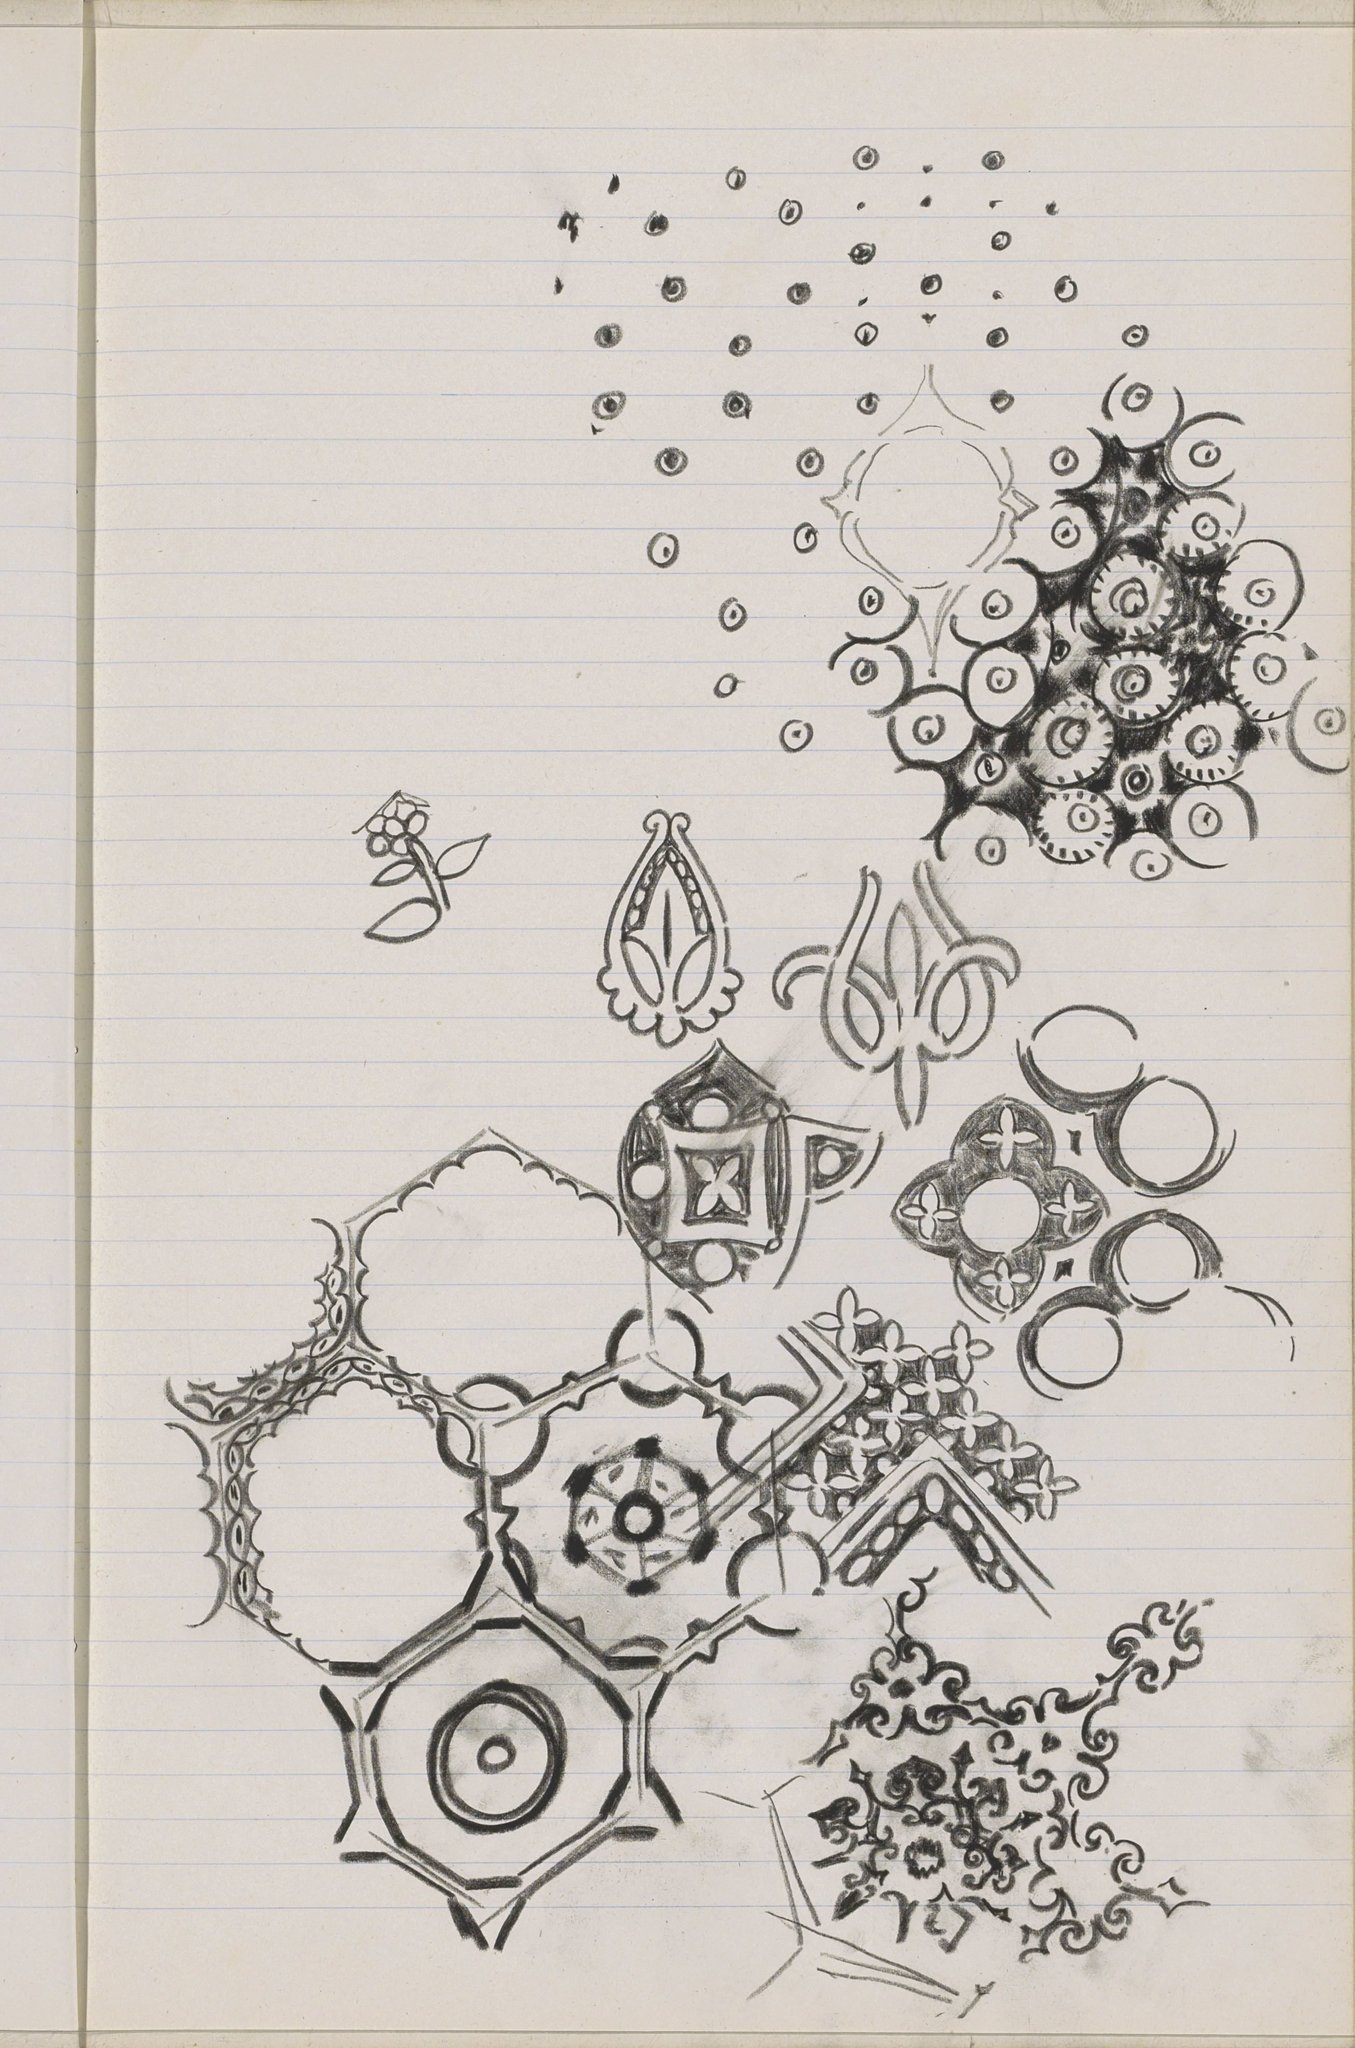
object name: sketchbook leaf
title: Ornamenten met bloem-, plant- en cirkelmotieven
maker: gerrit willem dijsselhof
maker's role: designer, draughtsman, print maker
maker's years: 1866-1924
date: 1901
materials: chalk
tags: ornament derived from plant forms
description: Blad 69 recto uit een schetsboek met 79 bladen.